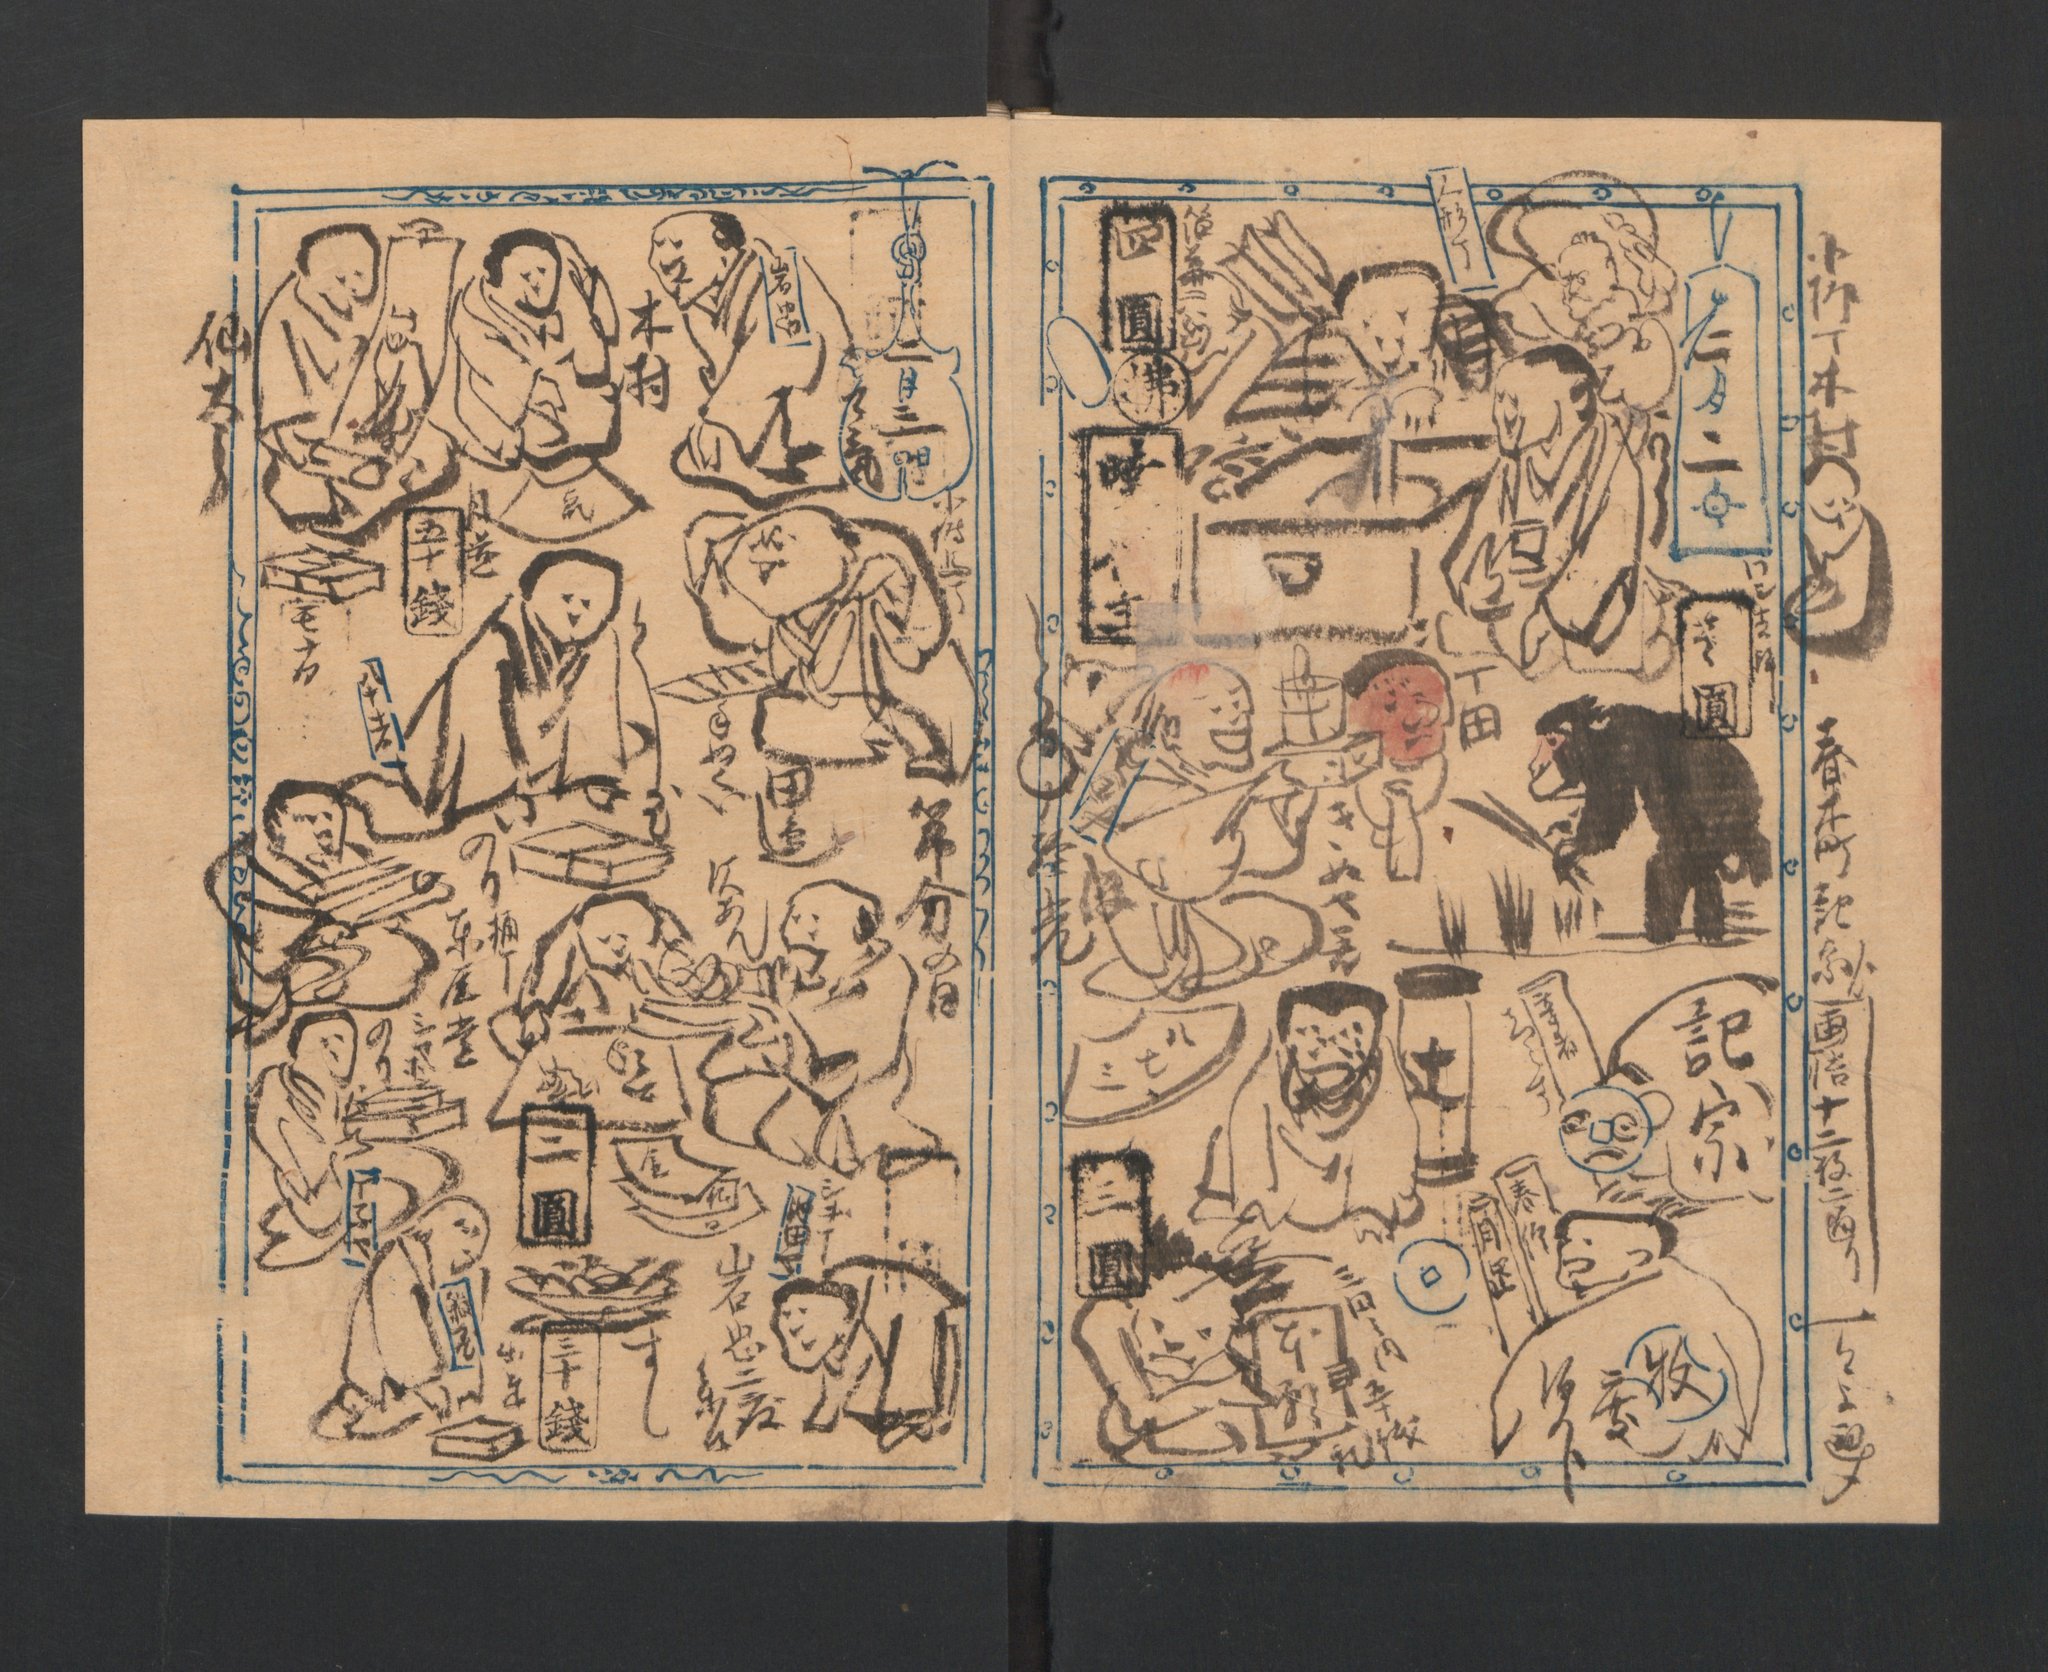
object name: illustrated book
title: Illustrated Diary (Kyōsai Enikki) 暁斎絵日記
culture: japanese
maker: kawanabe kyōsai 河鍋暁斎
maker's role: artist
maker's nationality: japanese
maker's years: 1831-1889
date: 1888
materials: ink, paper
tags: men